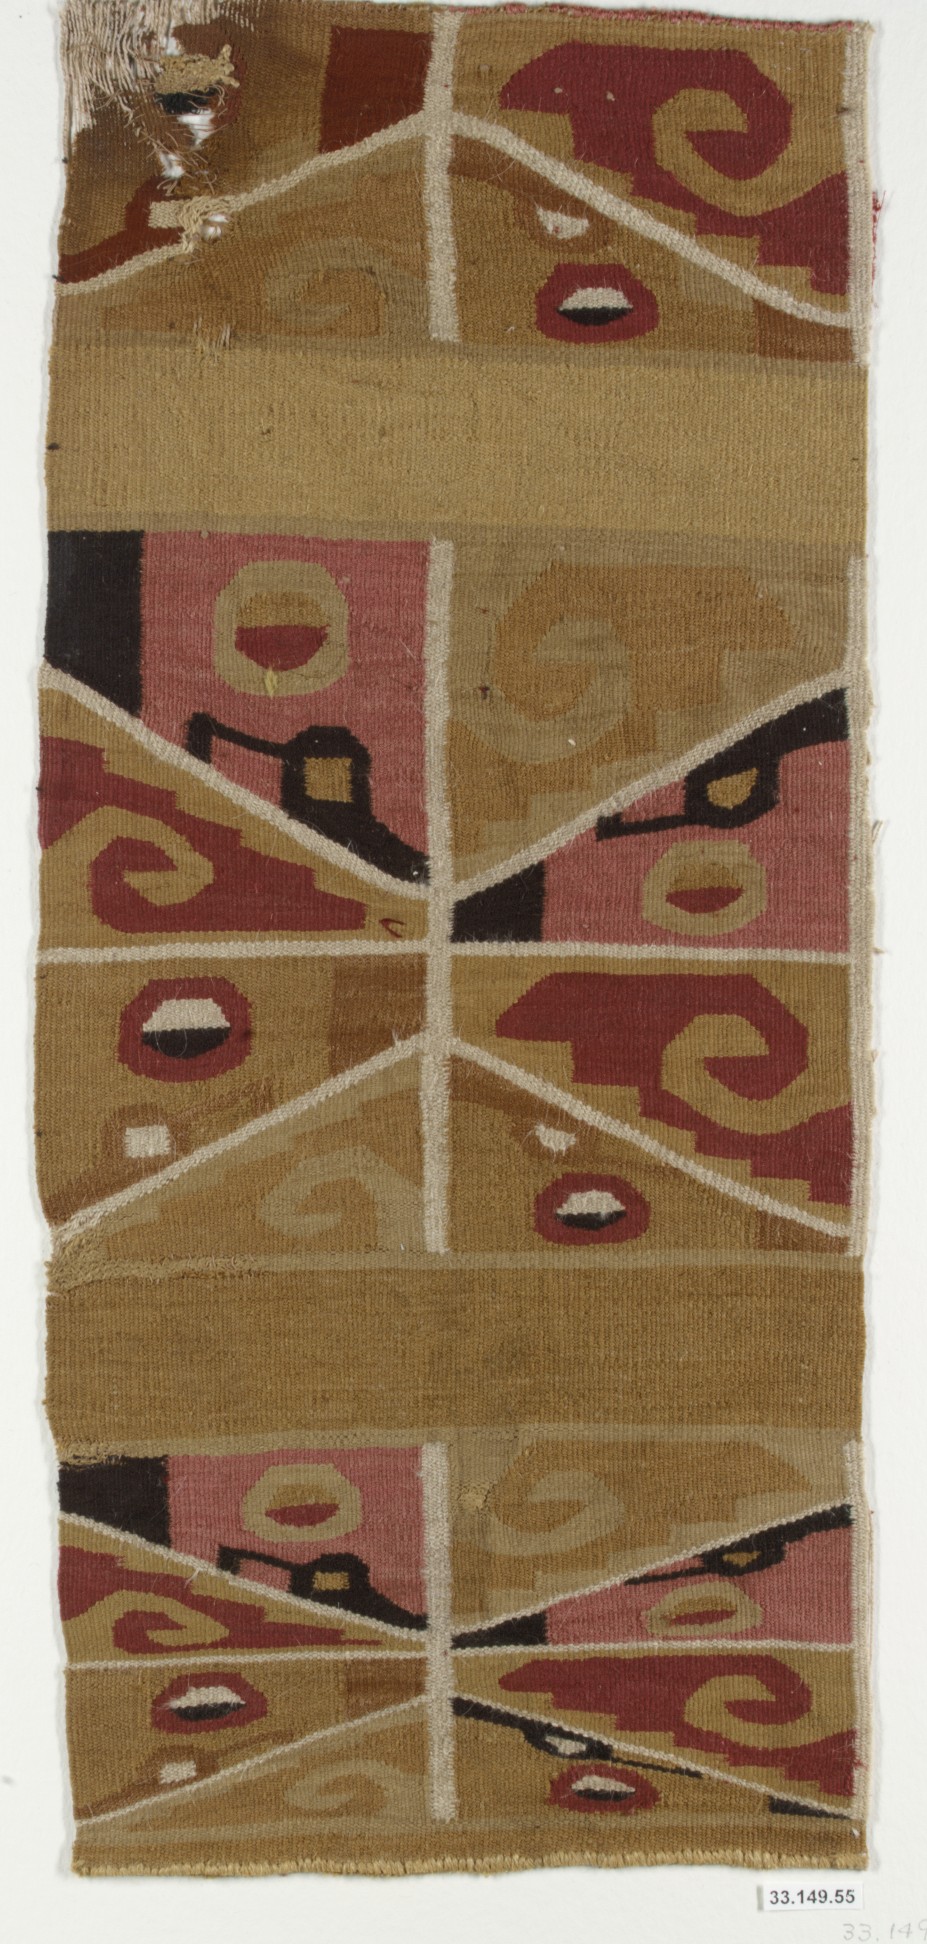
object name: tunic fragment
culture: wari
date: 601-900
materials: animal fiber, cotton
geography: peru